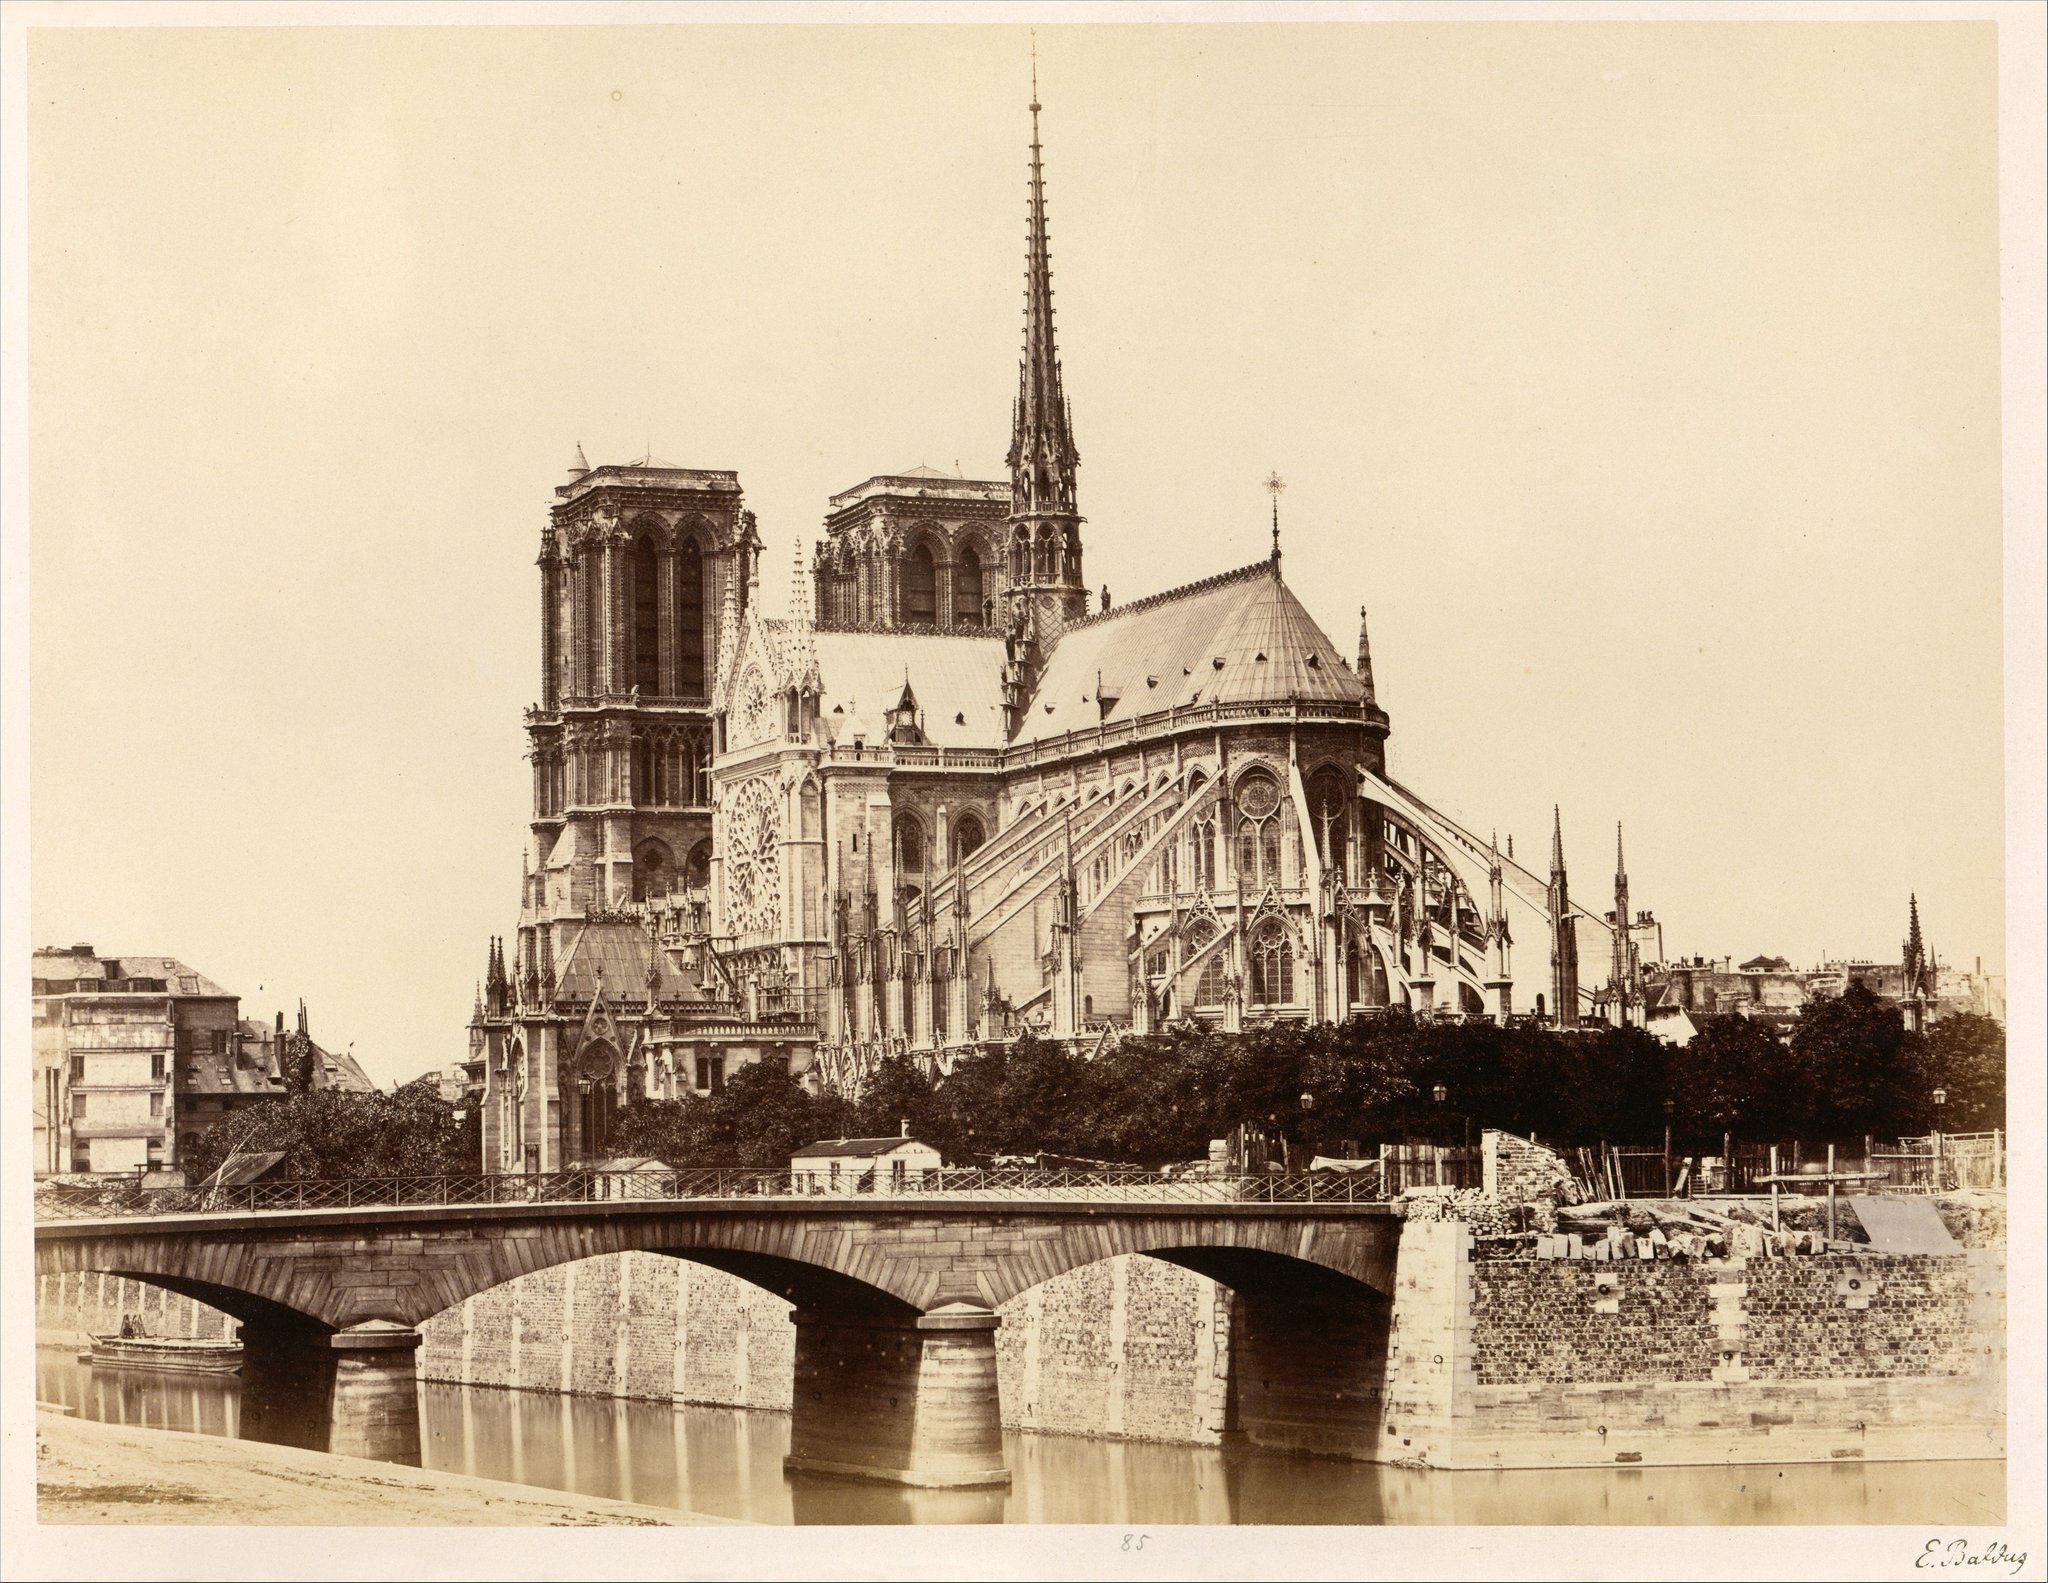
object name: photograph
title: Notre-Dame (Abside)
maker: édouard denis baldus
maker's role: fotograaf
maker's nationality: french, born prussia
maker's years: 1813-1889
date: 1860-1869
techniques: albumen silver print, glass negative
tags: architecture,bridges,cathedrals